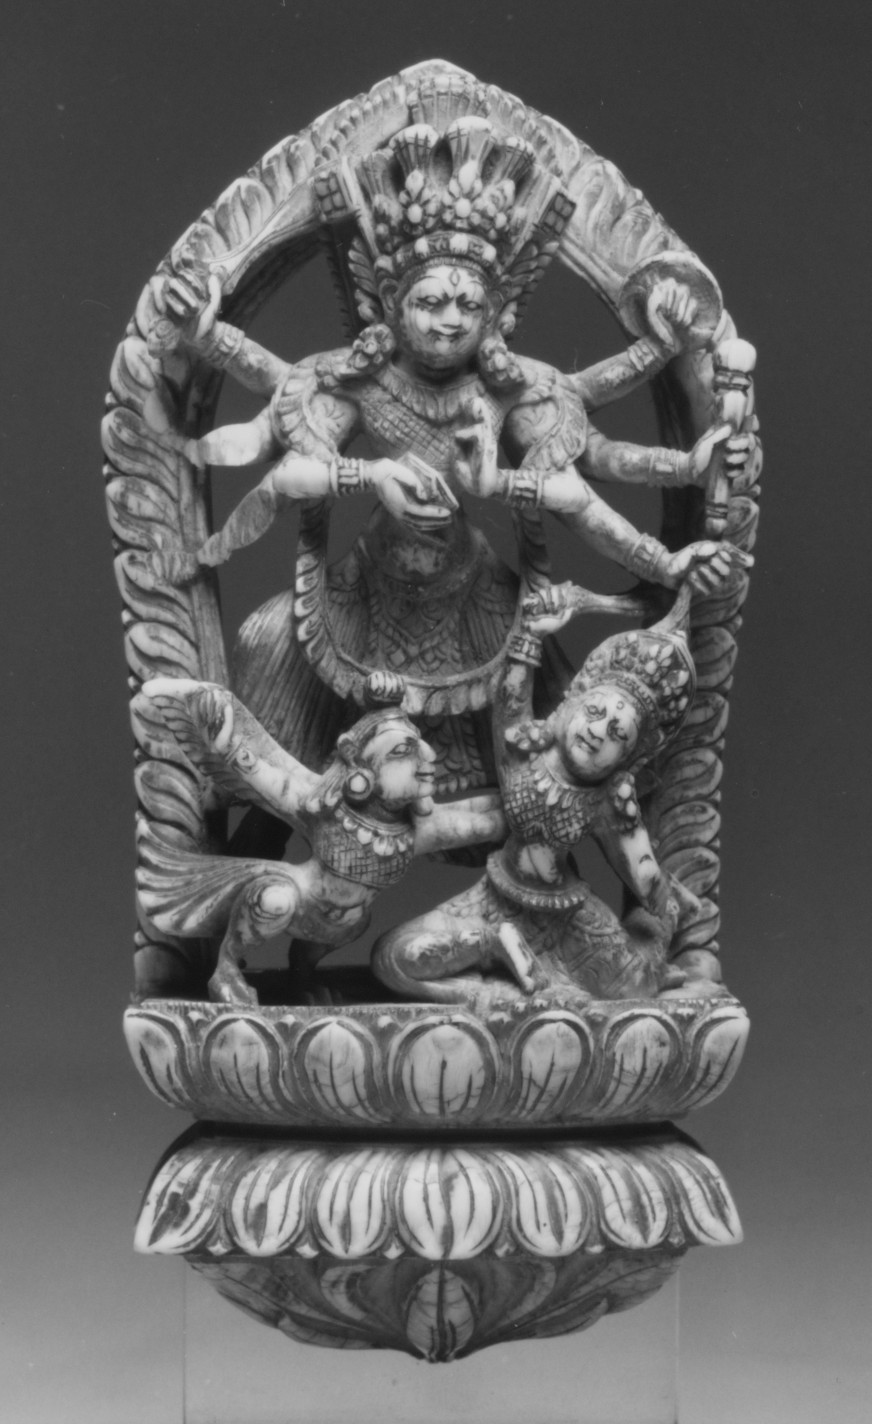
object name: figure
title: Wrathful Eight-Armed Goddess Slaying a Demon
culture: nepali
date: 1501-1700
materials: ivory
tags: demons,goddess